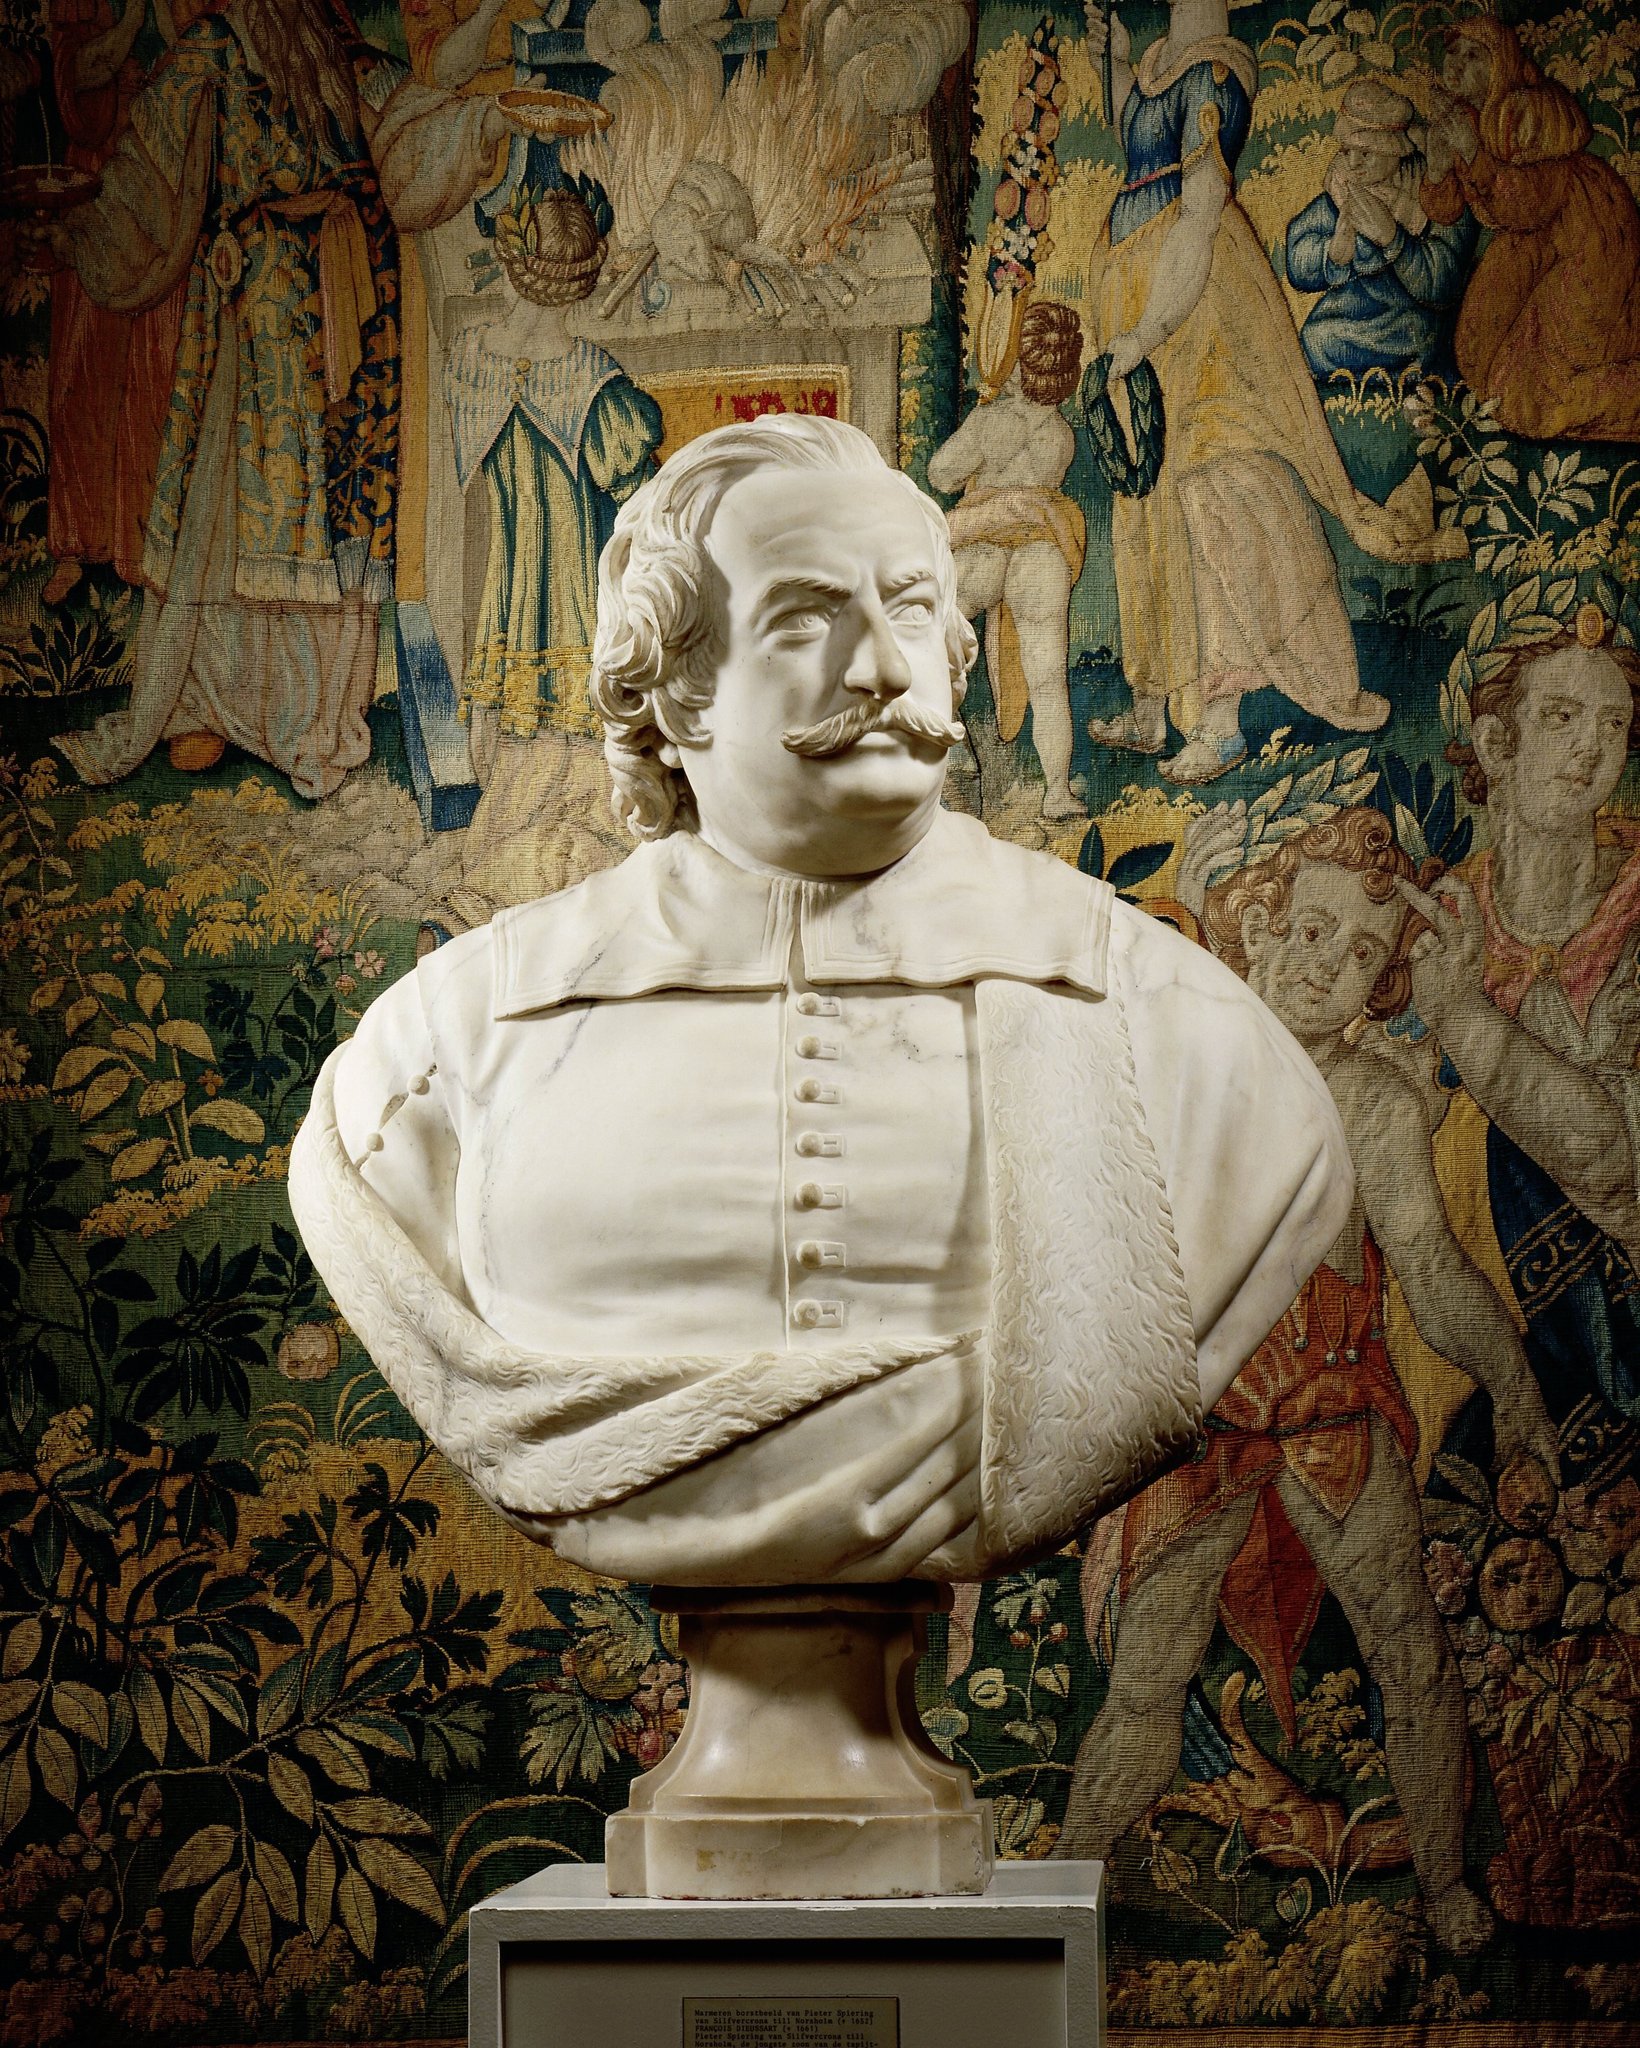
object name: sculpture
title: Portrait of Pieter Spiering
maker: françois dieussart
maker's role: sculptor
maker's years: 1600-1661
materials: marble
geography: the hague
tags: pieter spiering, historical persons (+ (full) bust portrait)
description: The Flemish sculptor Dieussart was a very popular portraitist at princely courts throughout northern Europe. In The Hague, he worked for Stadtholder Frederick Henry, but he also portrayed wealthy citizens, such as the Delft tapestry-weaver Pieter Spiering and his wife, Johanna Doré.